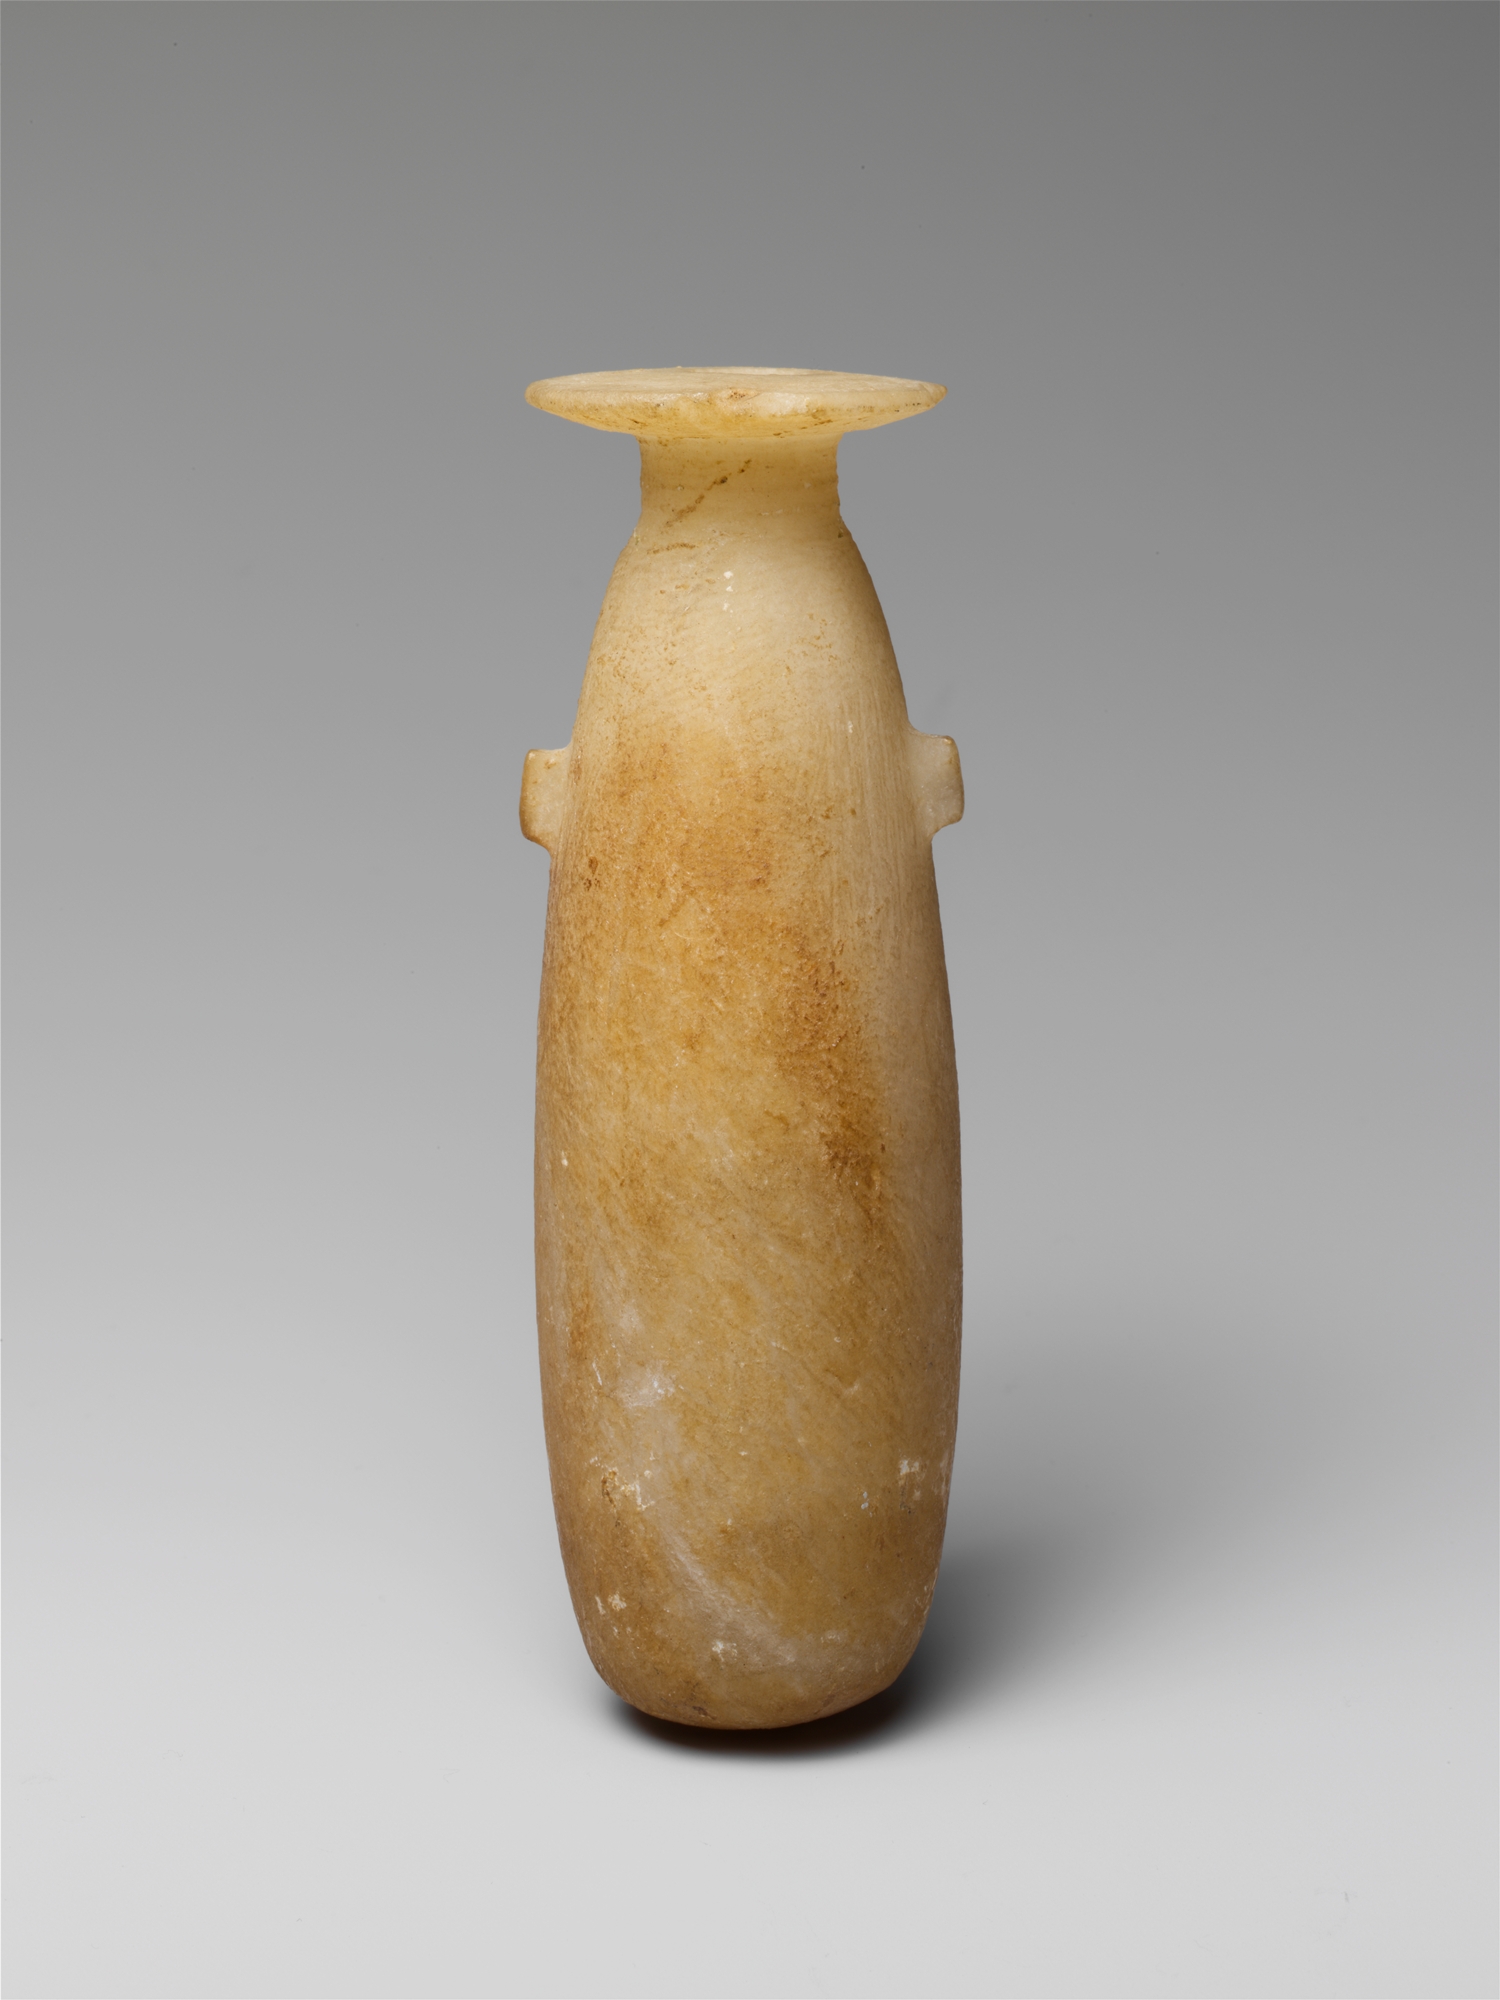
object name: alabastron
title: Alabaster alabastron (perfume vase)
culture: cypriot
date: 500-301 BCE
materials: gypsum